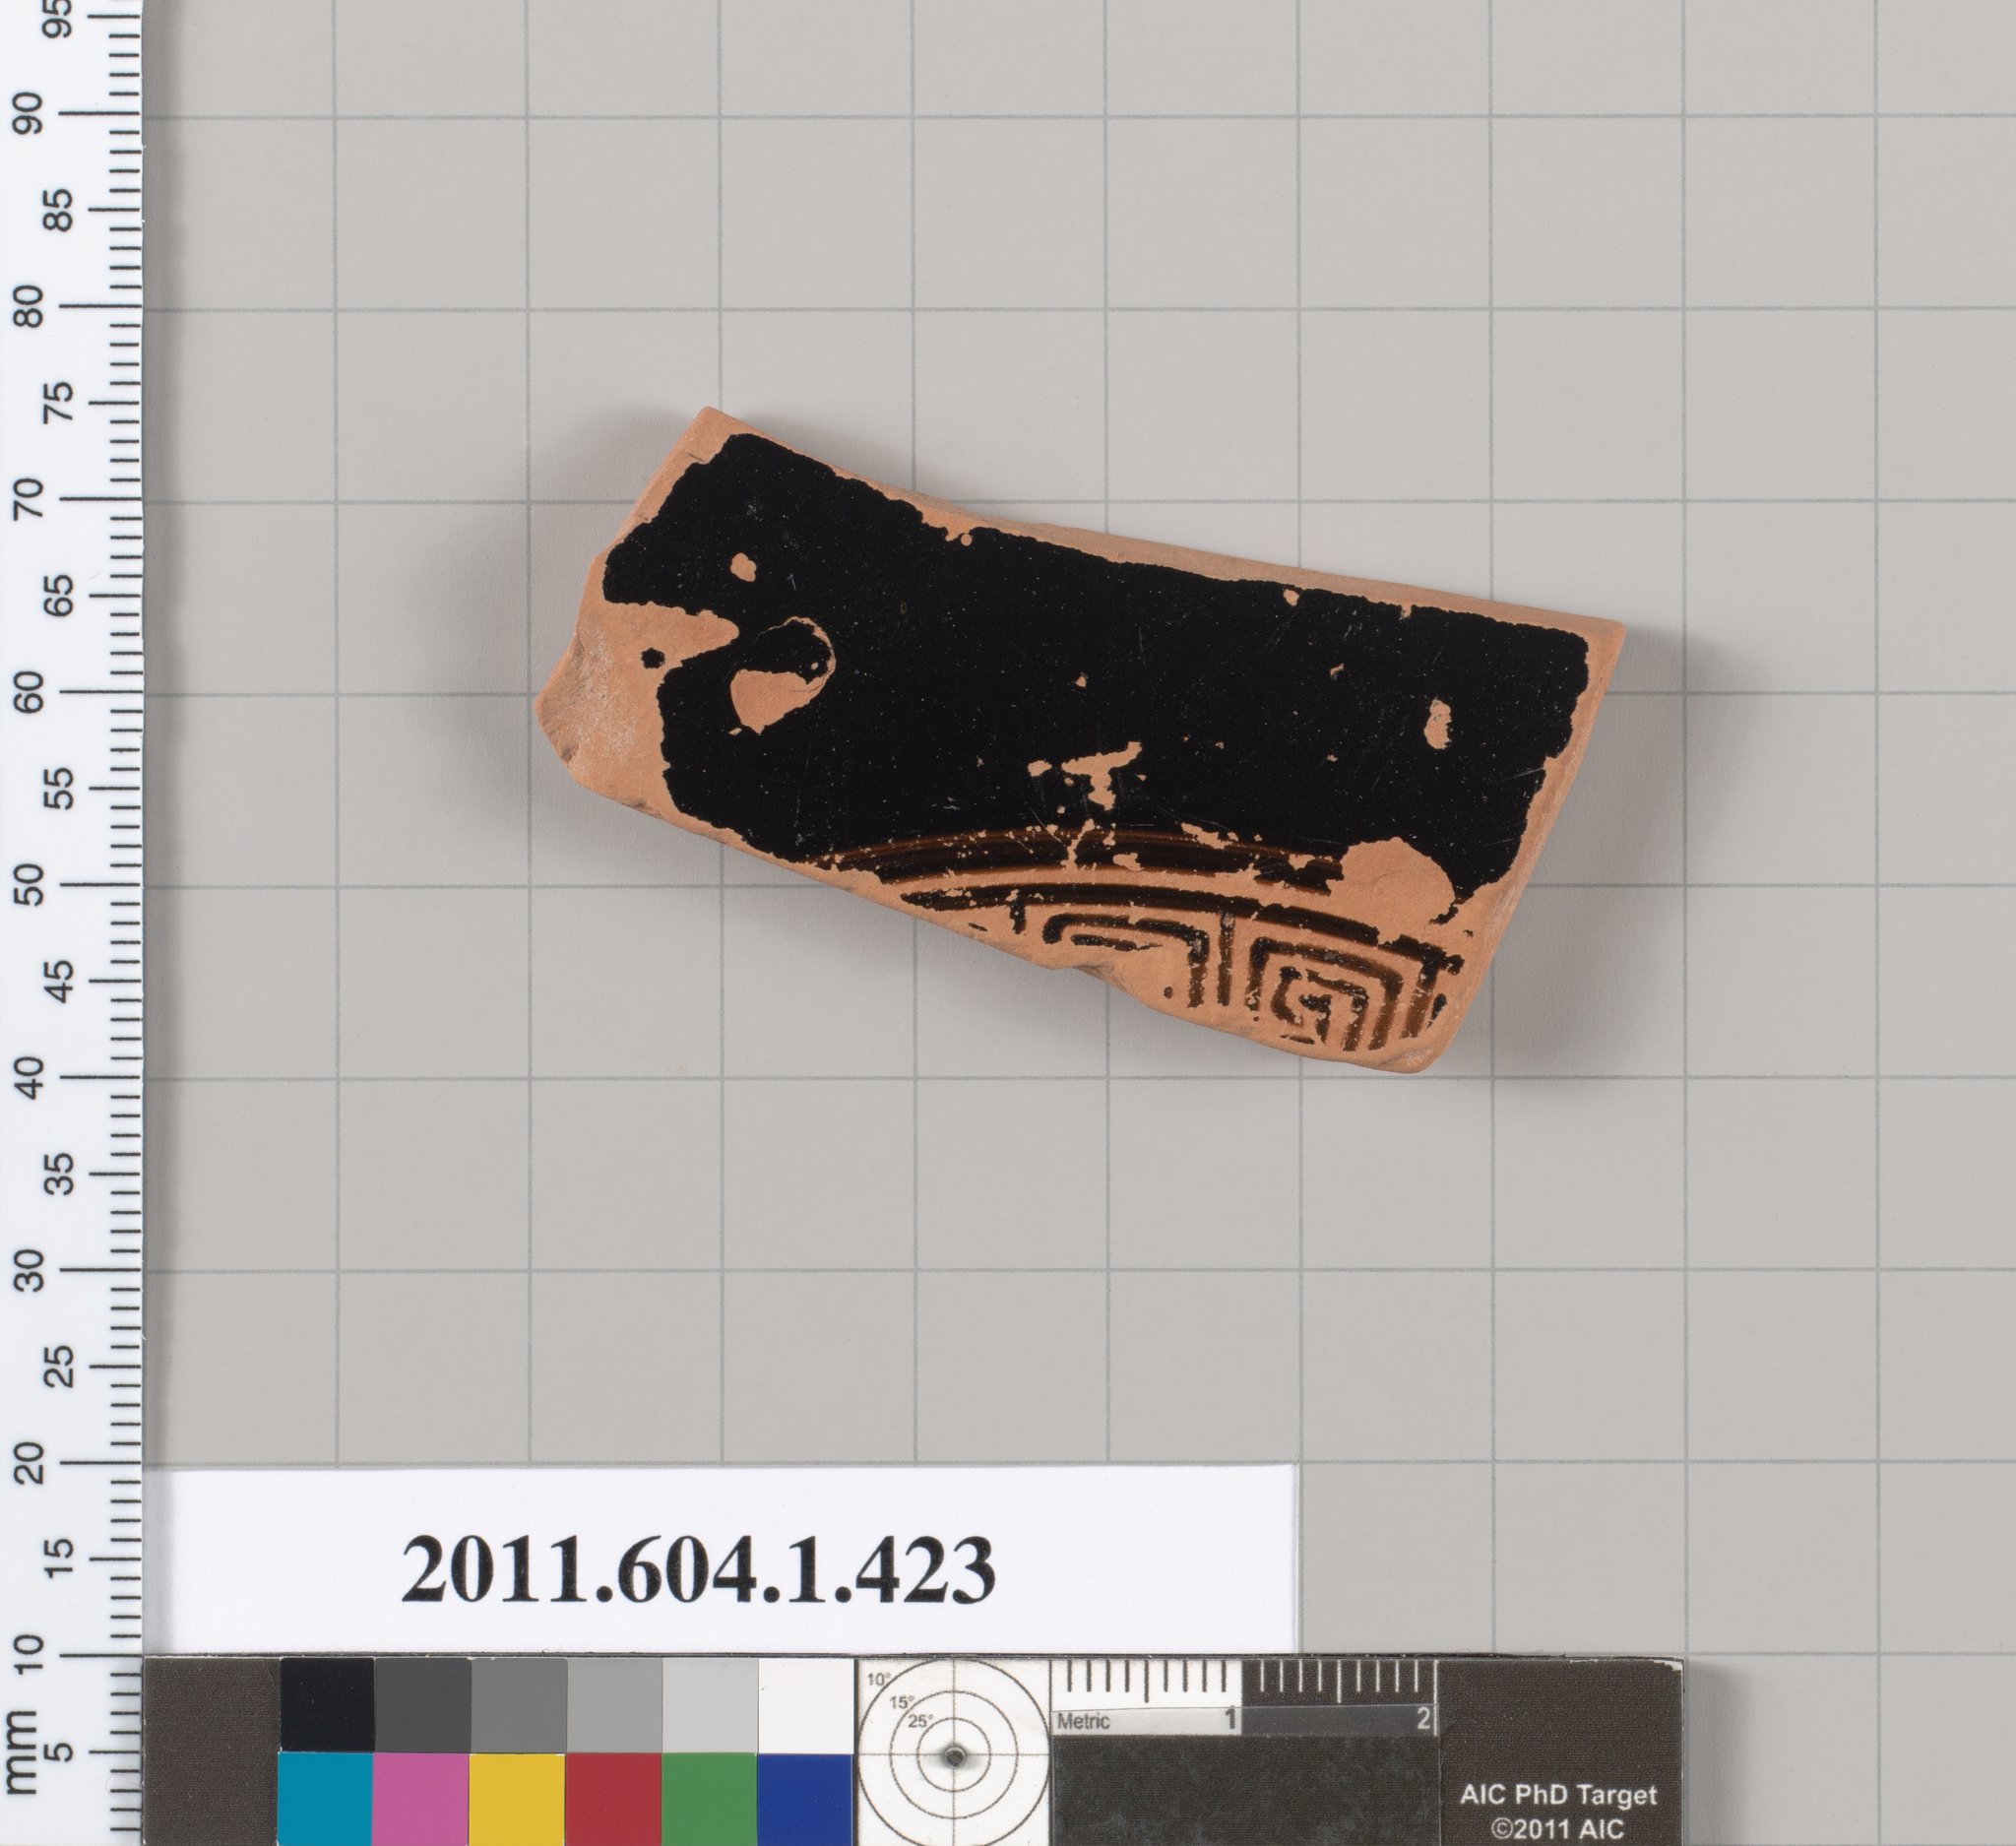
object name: kylix fragment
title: Terracotta fragment of a kylix (drinking cup)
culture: greek, attic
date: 475-451 BCE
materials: terracotta